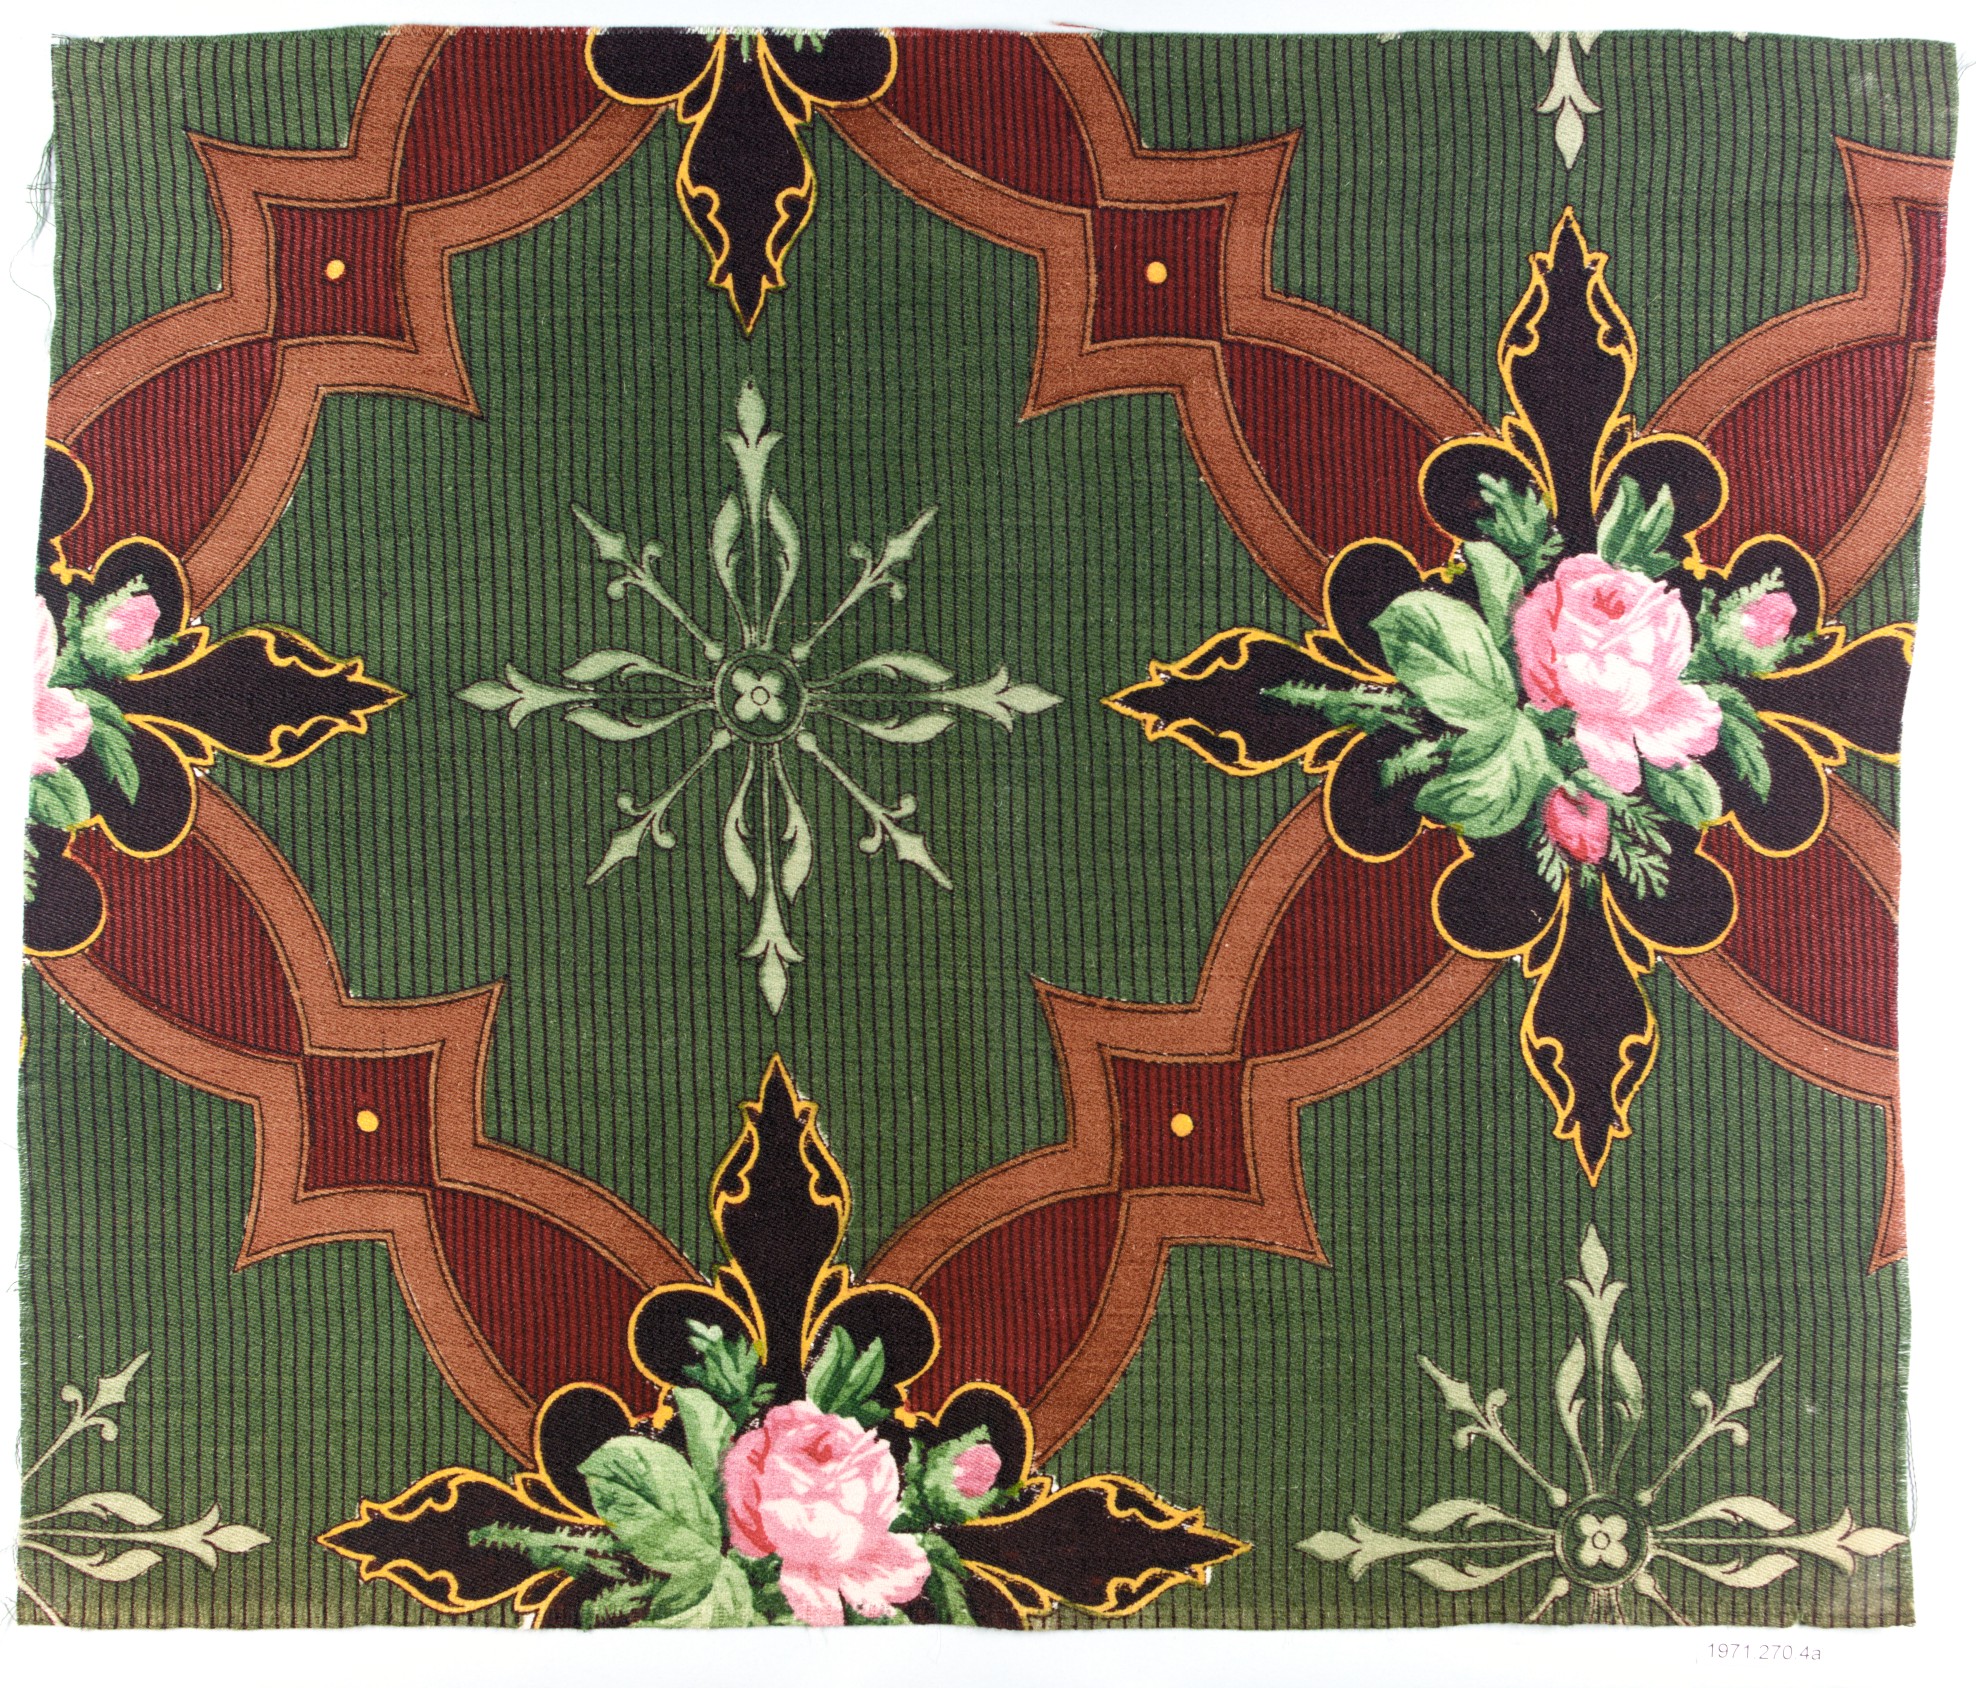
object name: sample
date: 1834-1866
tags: flowers